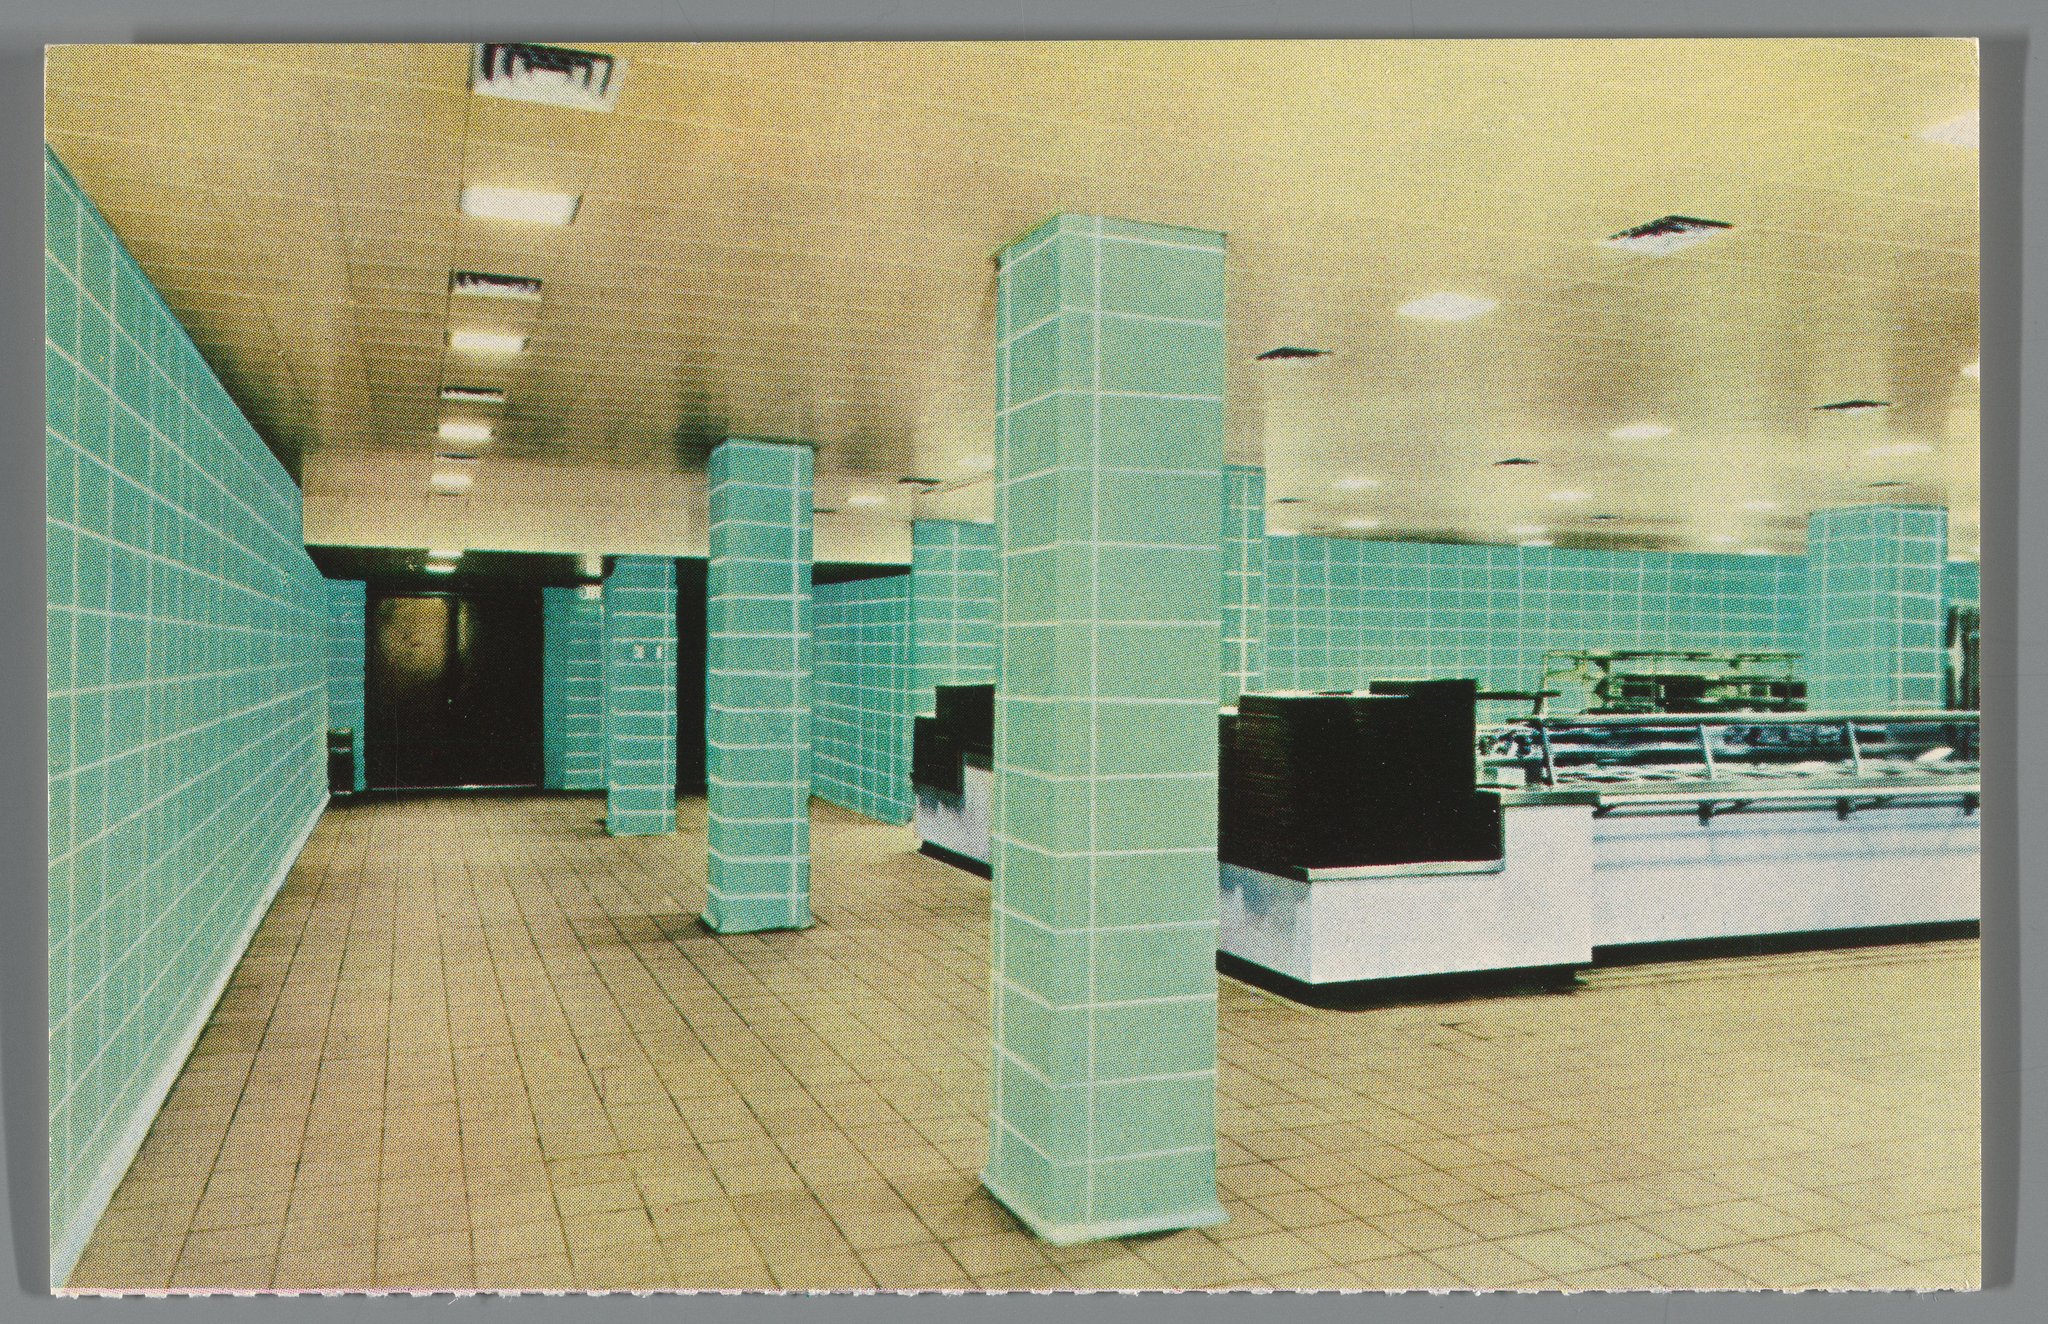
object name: ansichtkaart, prentbriefkaart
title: Reclame voor Spectra Glaze tegelwerk (Chicago)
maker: Anonymous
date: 1960-1975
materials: cardboard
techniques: four-color autotype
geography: united states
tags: chicago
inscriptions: inscription: ‘Spectra Glaze […] CURTEICHCOLOR ® 3-D NATURAL COLOR REPRODUCTION (REG. U.S.A. PAT. OFF.) / […] / BUSINESS REPLY CARD / […] / STRUCTURAL GLAZED MASONRY, Inc. / 1215 E 73rd STREET, / CHICAGO 19, ILLINOIS’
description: Dubbele prentbriefkaart, ‘business reply card’.